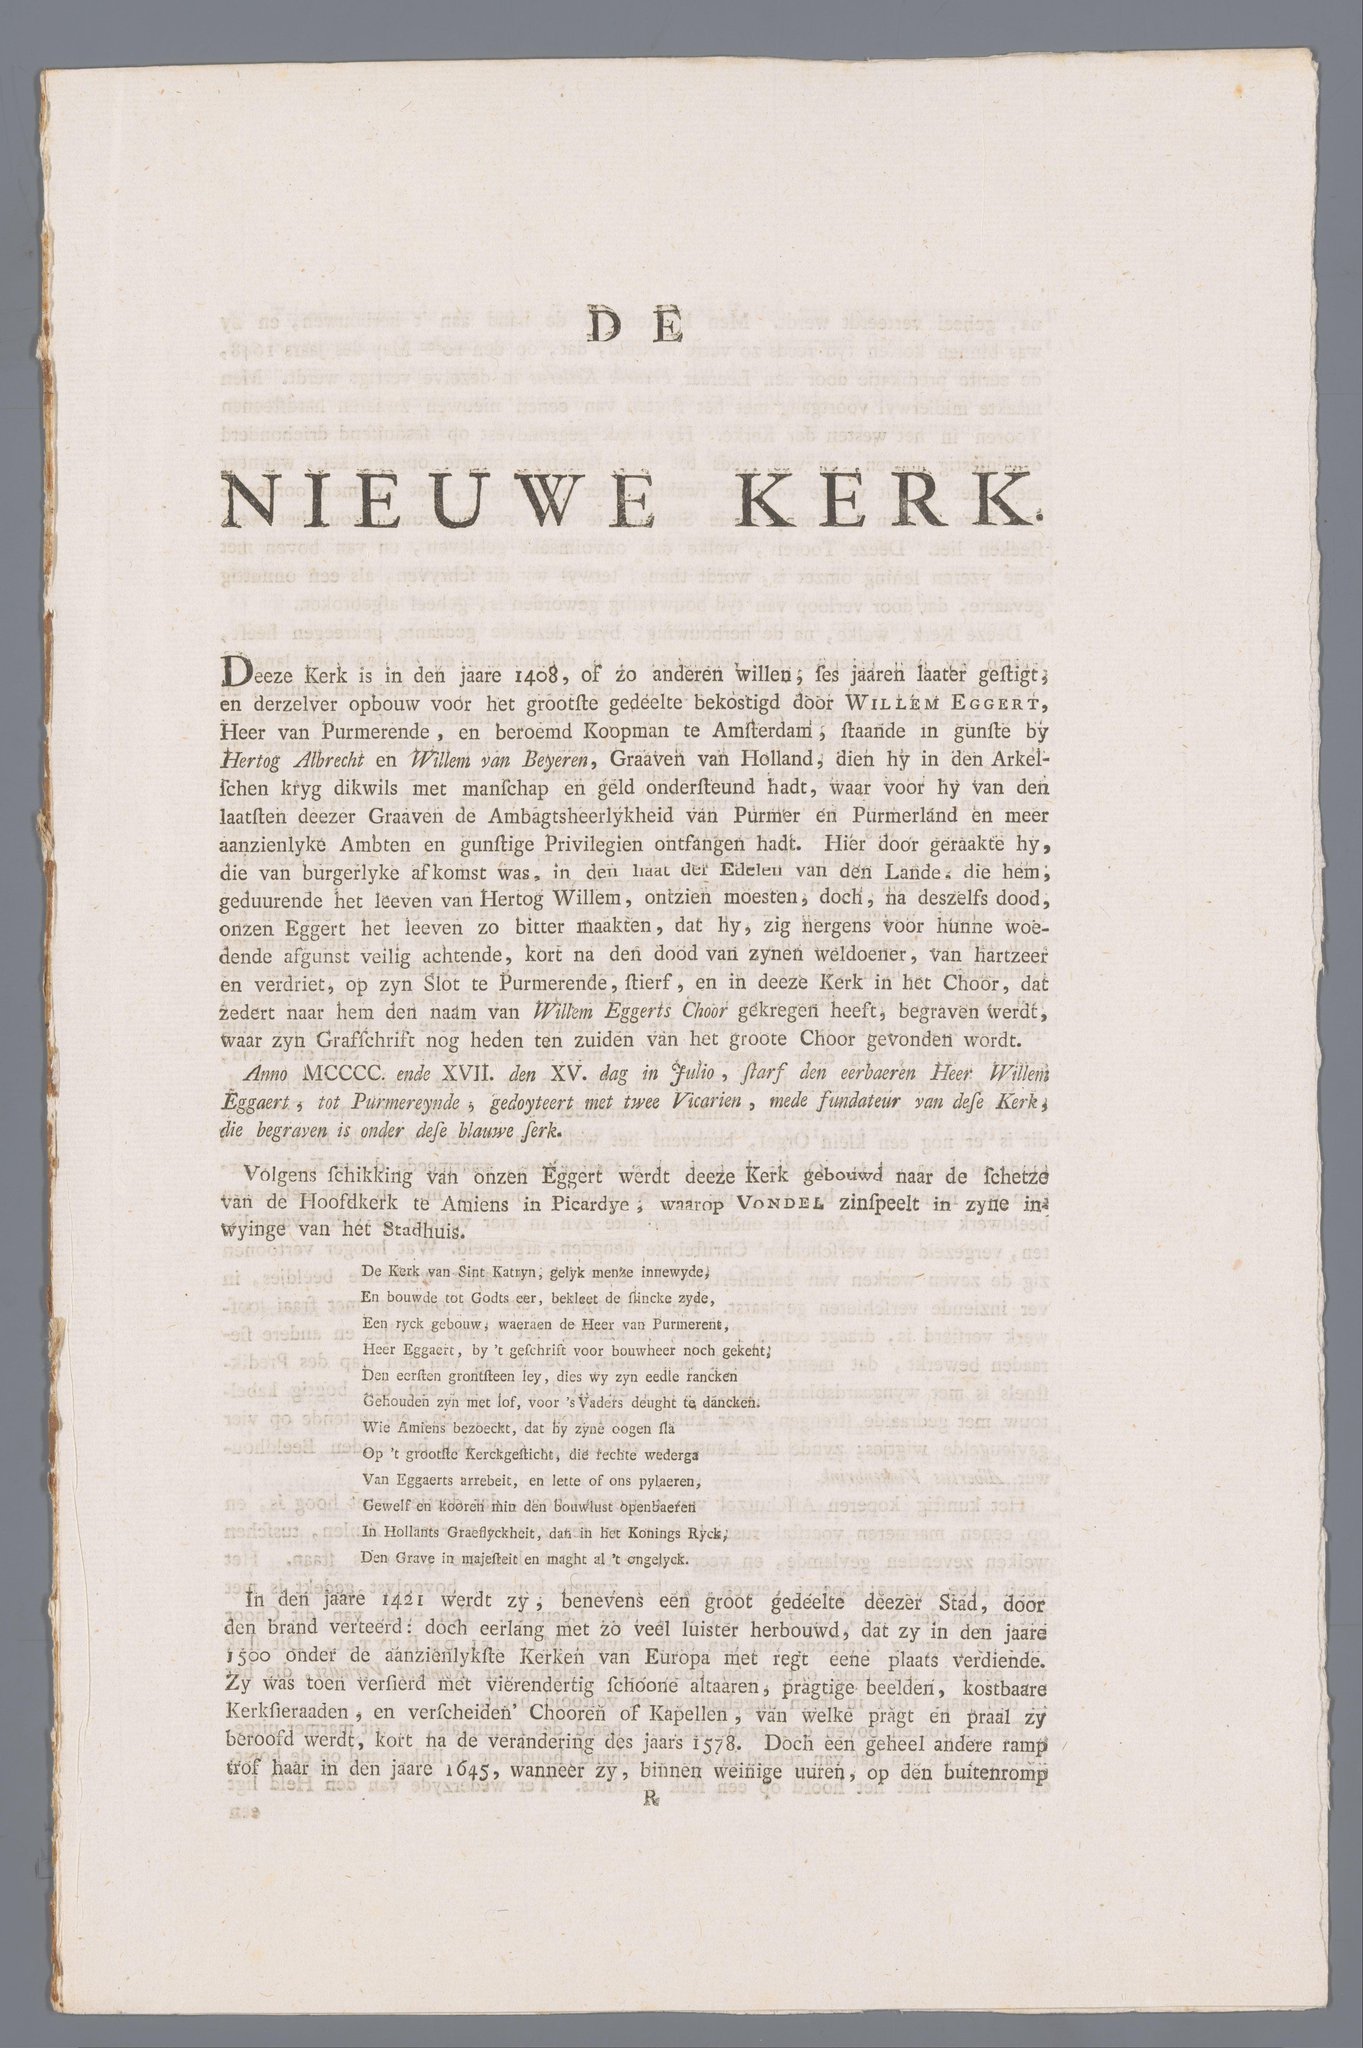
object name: page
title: Beschrijving van de Nieuwe Kerk te Amsterdam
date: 1783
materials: paper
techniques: letterpress printing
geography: netherlands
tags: protestant churches and denominations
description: Tekstbladen uit: Nieuwe atlas, van de voornaamste gebouwen en gezigten der stad Amsterdam, met derzelver beknopte beschryvingen. 2 dln. Amsterdam: Daniël Jean Changuion en Petrus den Hengst [in opdracht van Pierre Fouquet], 1783, dl. 2.